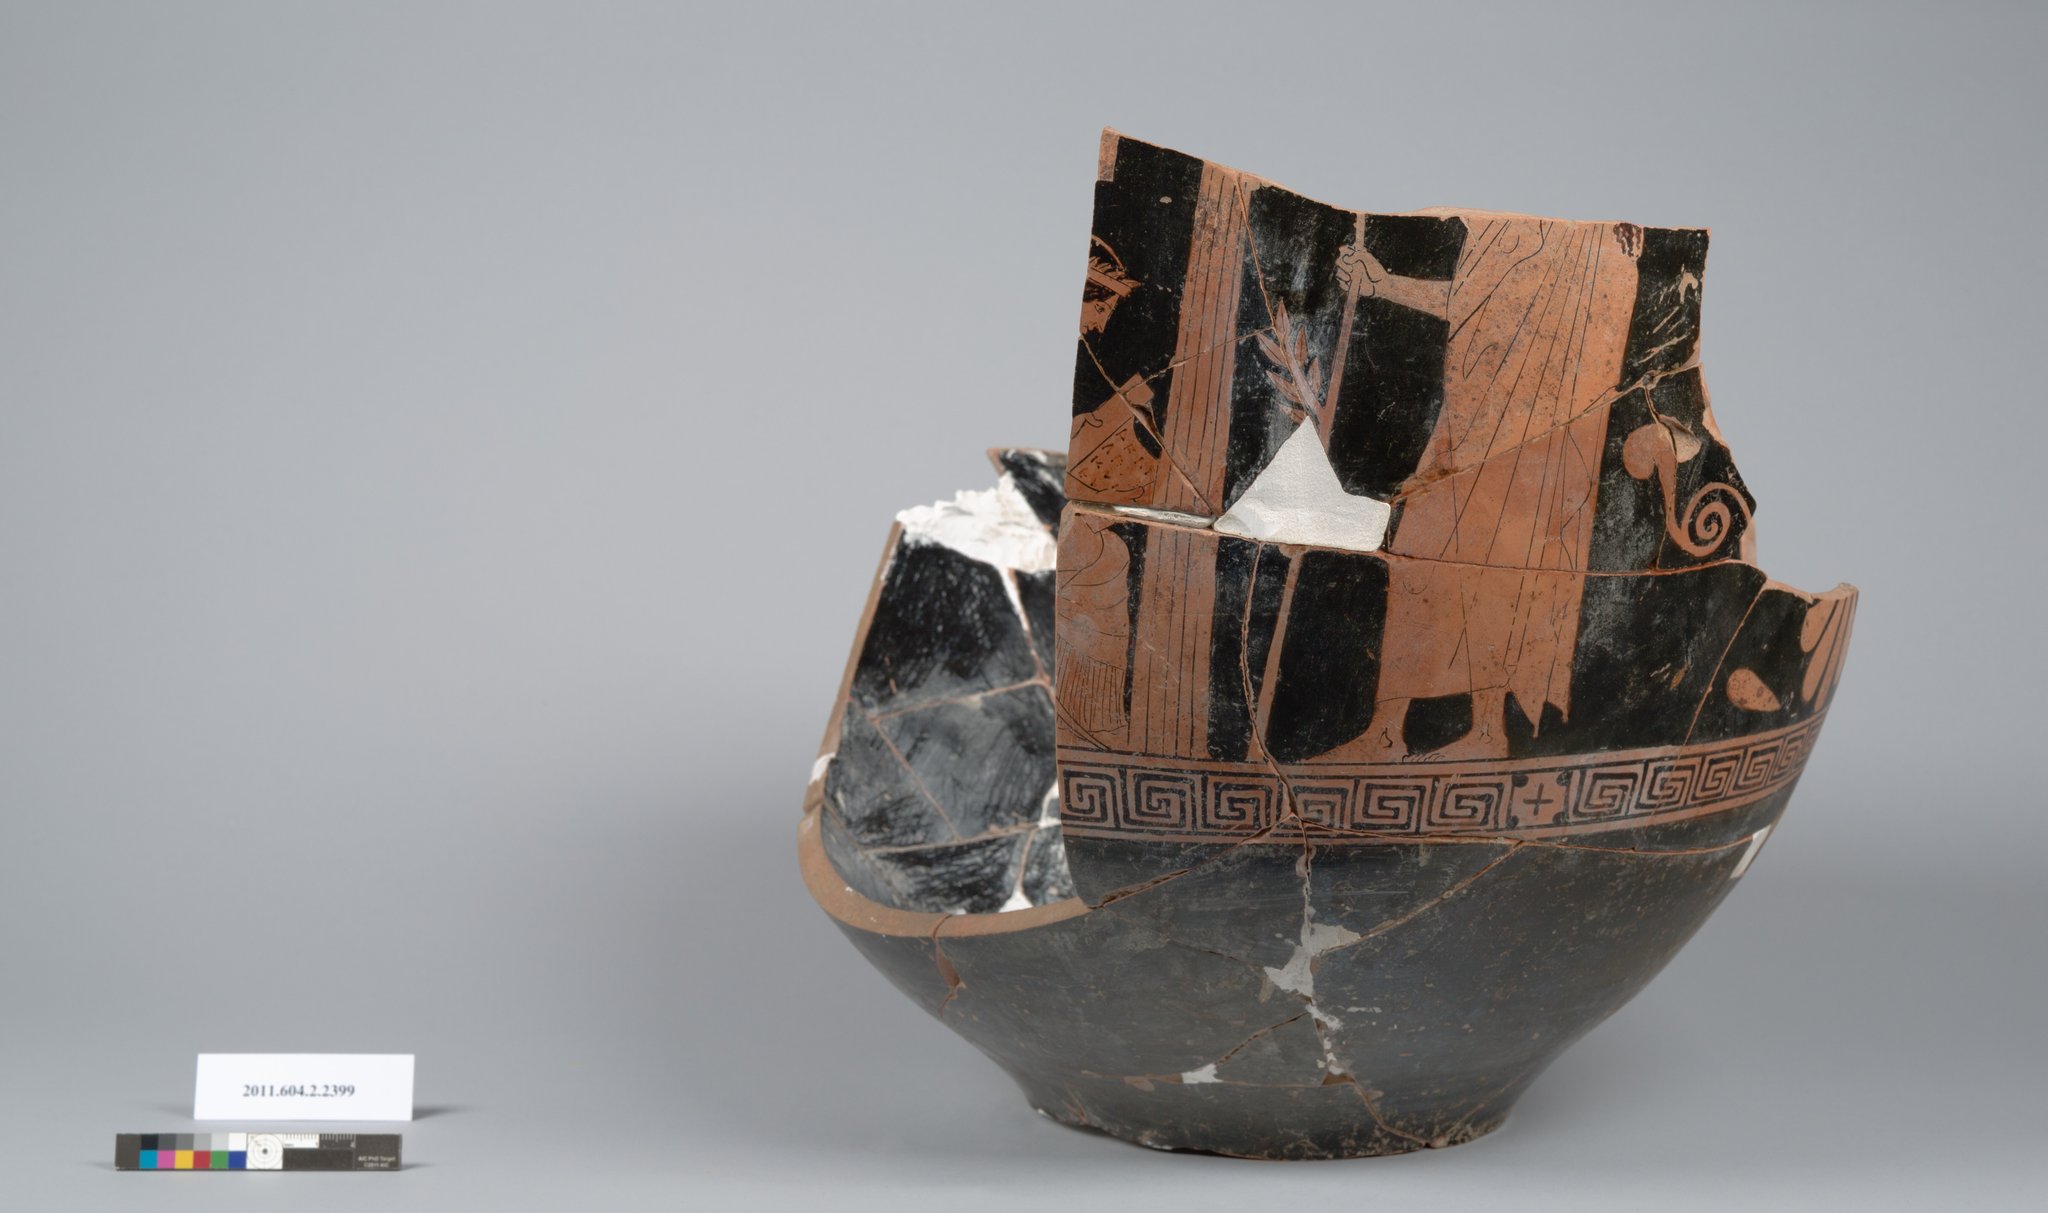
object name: bell krater fragment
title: Terracotta fragment of a bell-krater (bowl for mixing wine and water)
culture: greek, attic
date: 460-440 BCE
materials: terracotta